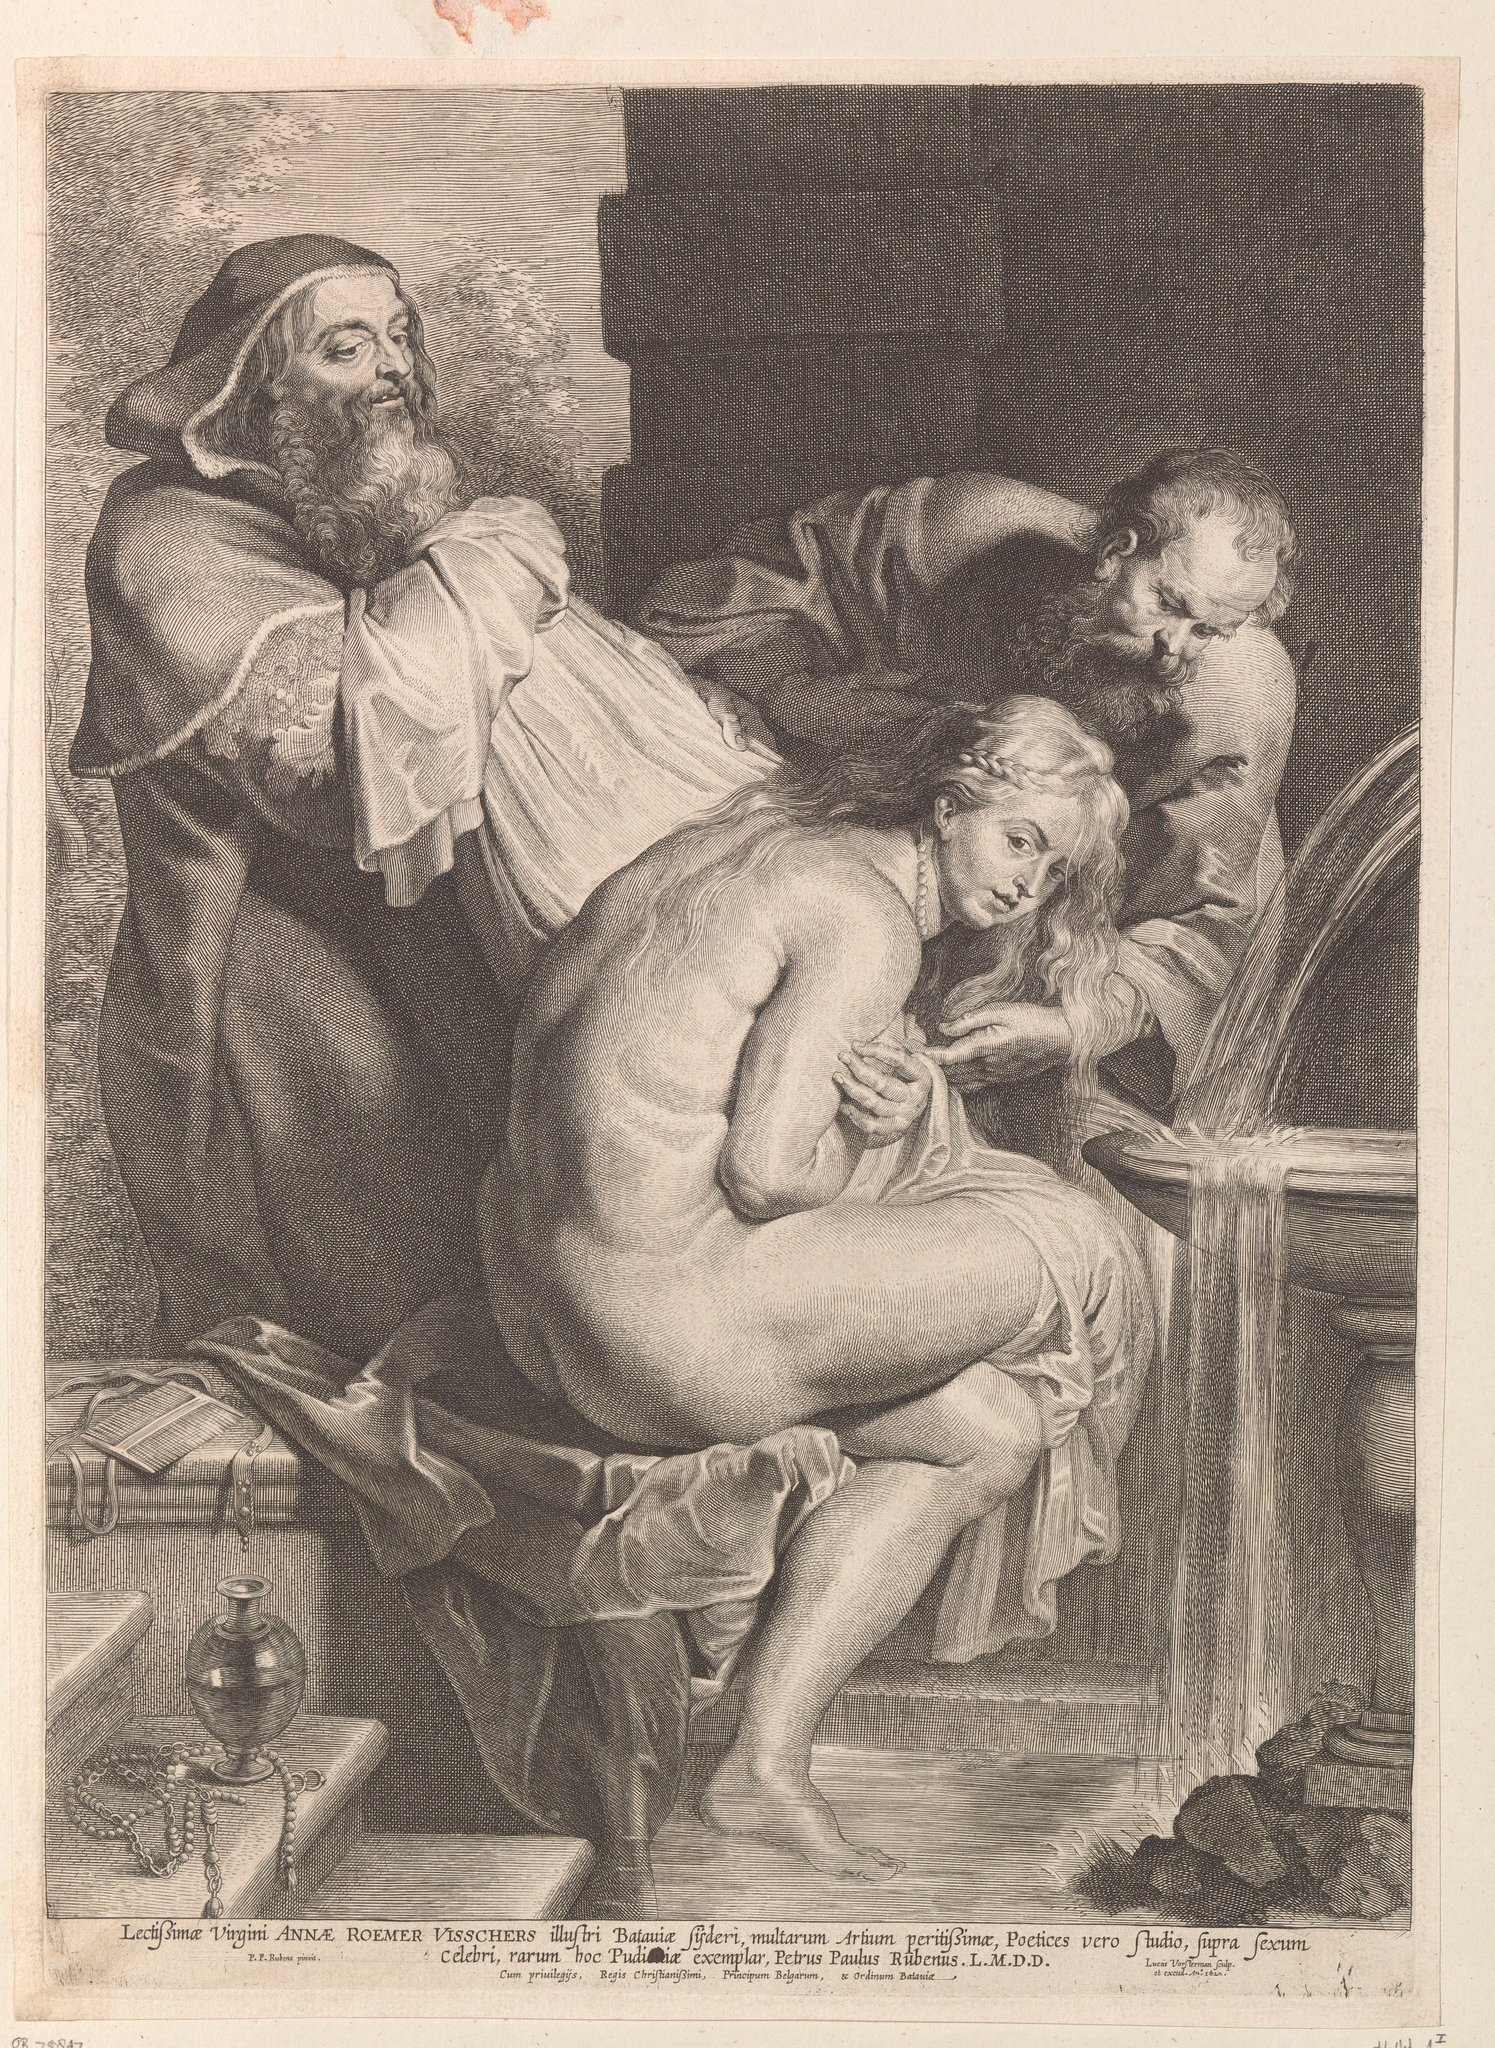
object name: print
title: Suzanna en de ouderlingen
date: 1620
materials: paper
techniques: engraving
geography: southern netherlands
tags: the elders making advances towards susanna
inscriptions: date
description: Deze prent maakt deel uit van een album.